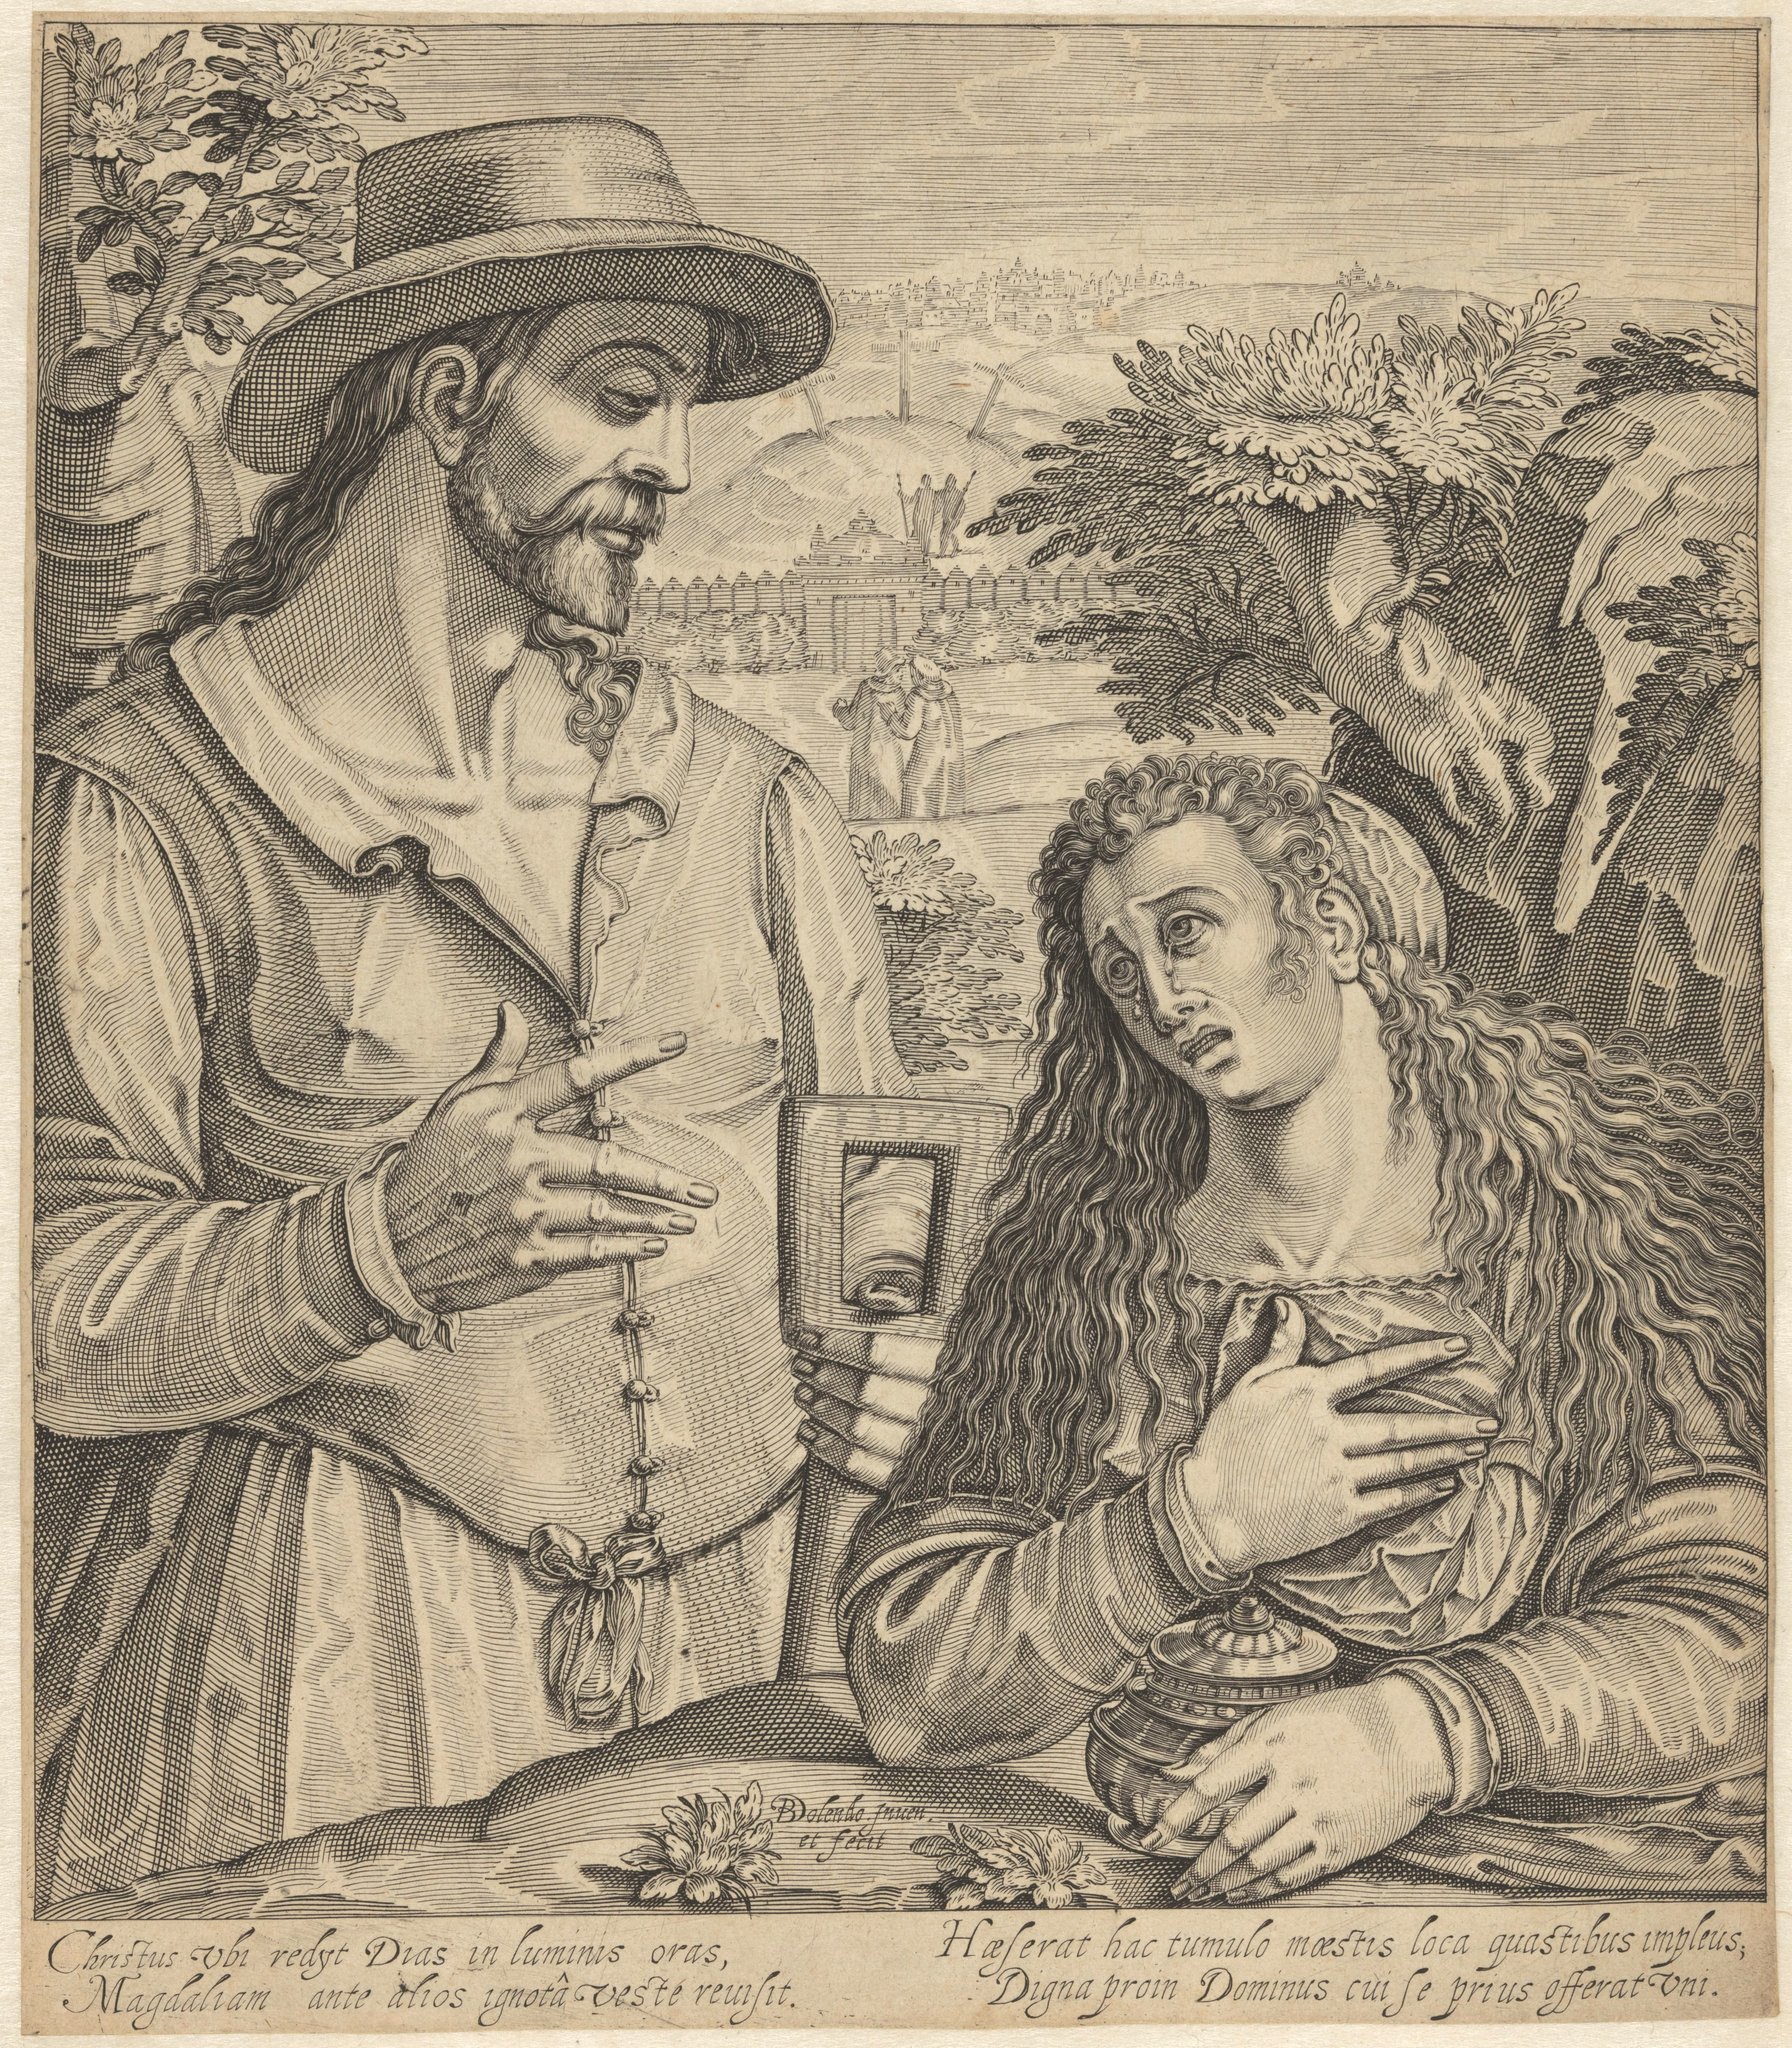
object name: print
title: Christus verschijnt aan Maria Magdalena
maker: bartholomeus willemsz. dolendo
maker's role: print maker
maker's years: 1560-1626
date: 1590-1600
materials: paper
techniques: engraving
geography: northern netherlands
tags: mary magdalene kneeling before christ, who is usually represented as a gardener with a hoe and/or a spade; 'noli me tangere'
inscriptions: collector's mark: Lugt 223, collector's mark: Lugt 2228, collector's mark: Lugt 2760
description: Noli me tangere. Christus verschijnt aan Maria Magdalena als tuinman met in zijn hand een schep en een hoed op zijn hoofd. Magdalena heeft een zalfpot in haar hand en weent. Op de achtergrond Golgotha met de drie kruisen en Jeruzalem. Met vierregelig onderschrift in het Latijn.